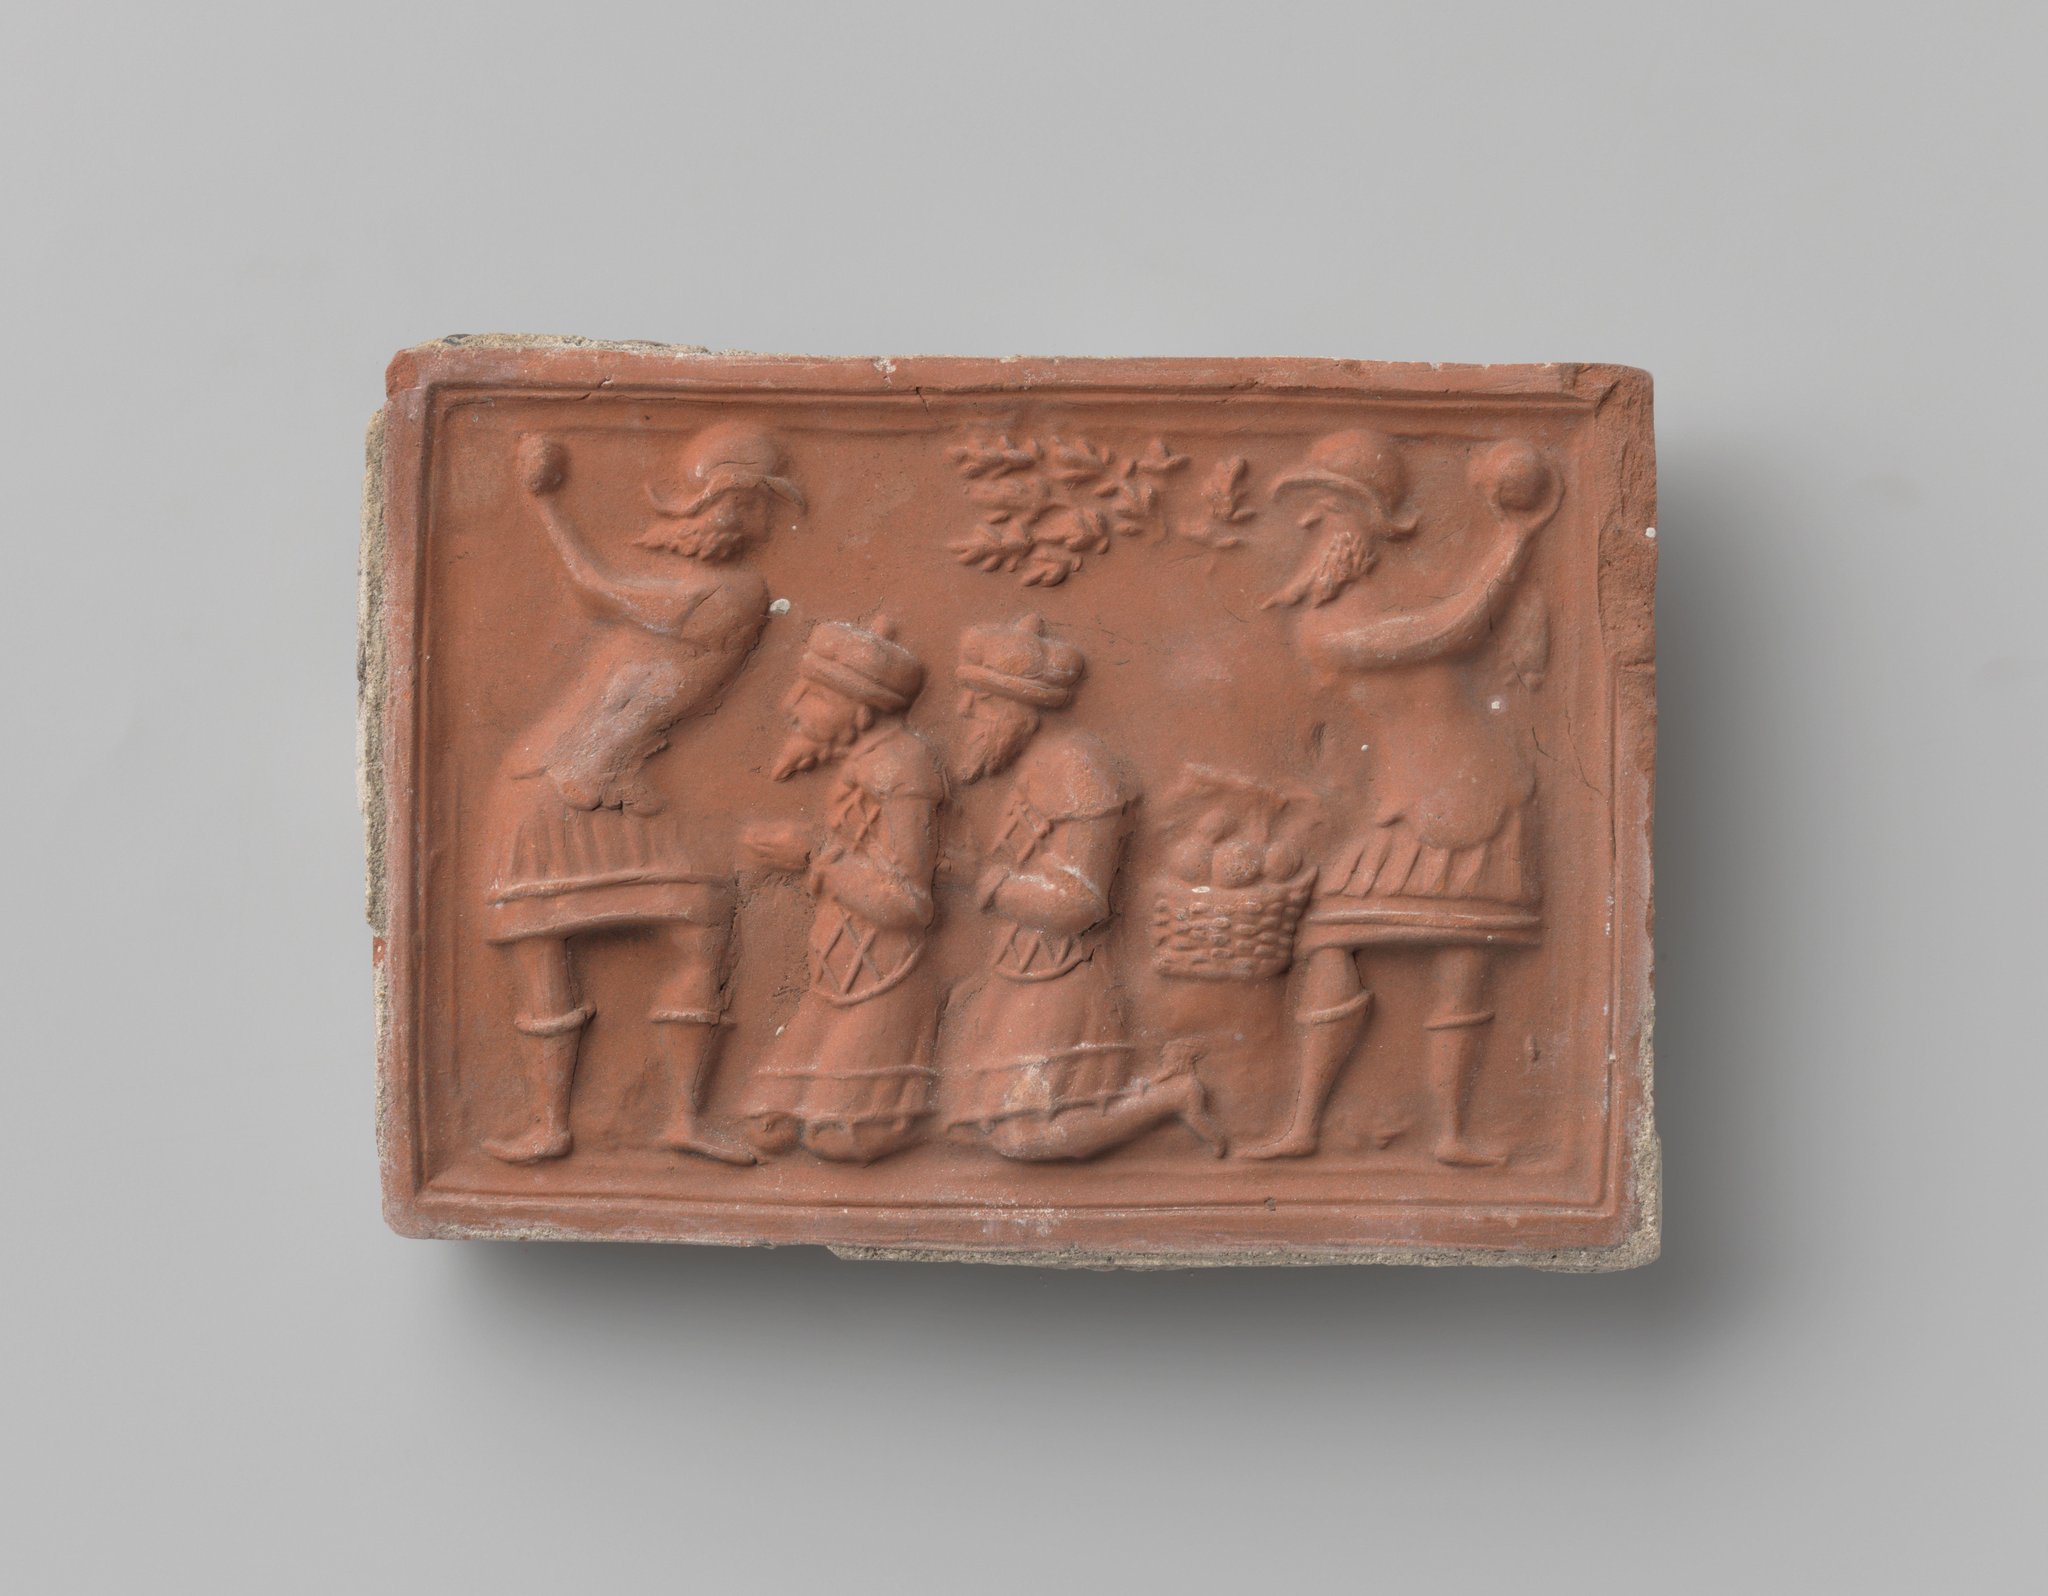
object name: hearthstone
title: Haardsteen met voorstelling van de beide ouderlingen uit de geschiedenis van Suzanna, die door twee soldaten worden gestenigd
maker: Anonymous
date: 1875-1900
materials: earthenware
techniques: printing, firing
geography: netherlands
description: Haardsteen met voorstelling van de beide ouderlingen uit de geschiedenis van Suzanna, die door twee soldaten worden gestenigd. Op de achtergrond een mand met stenen en een boom.